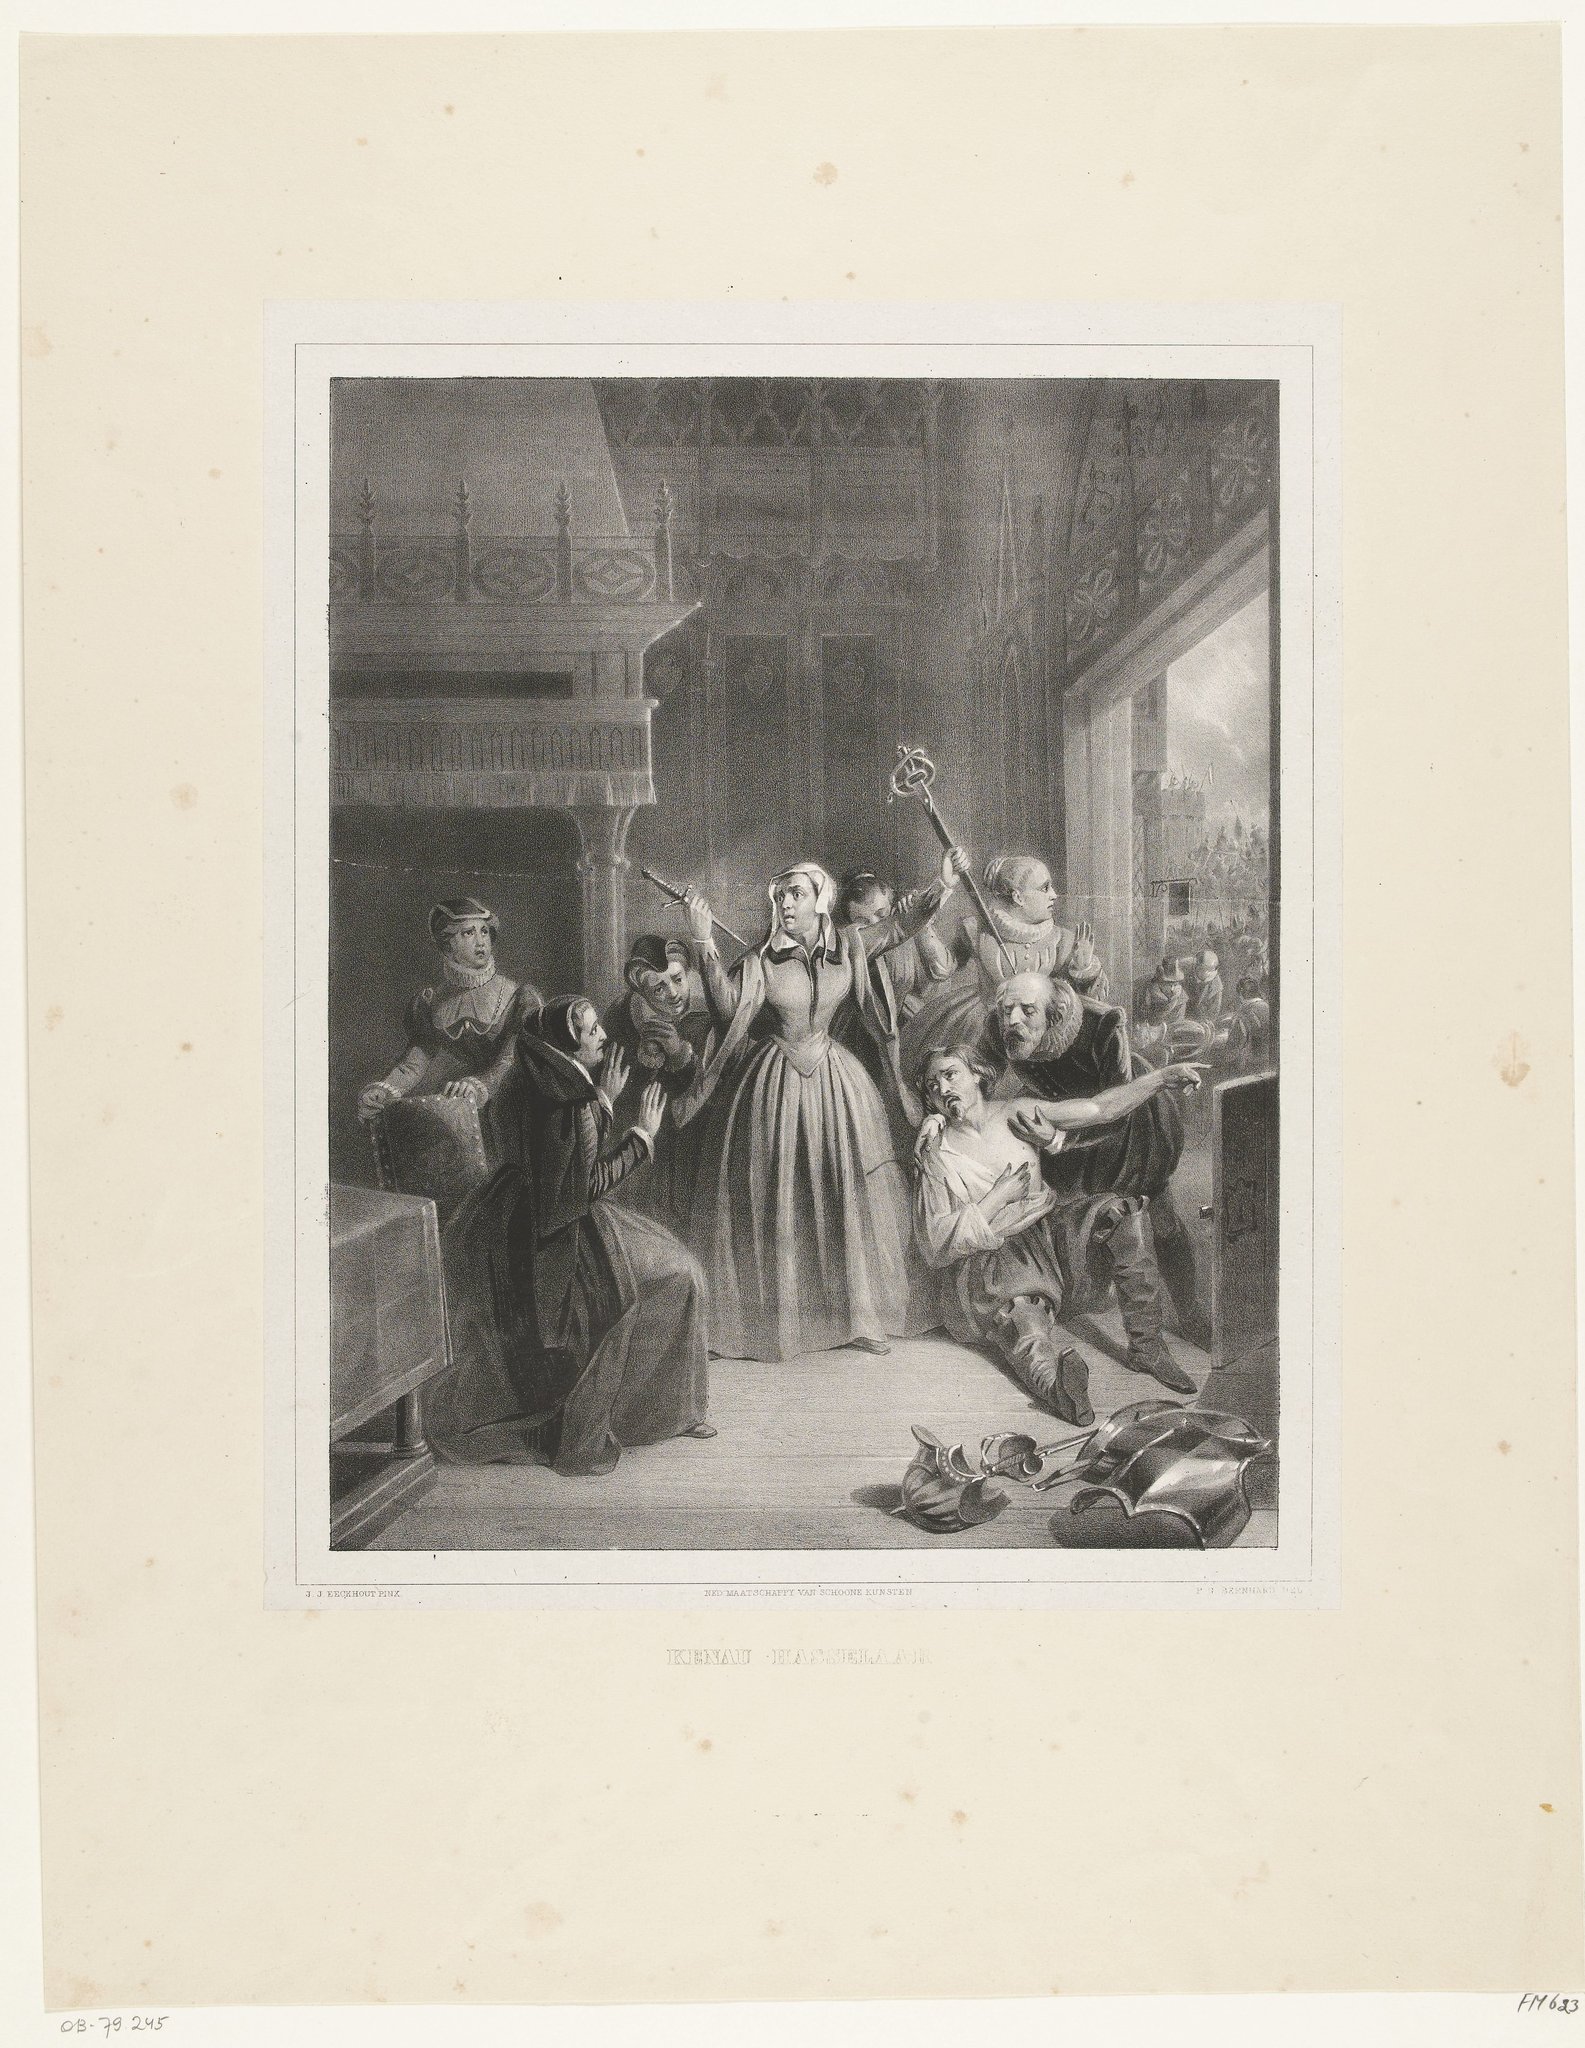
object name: history print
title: Kenau grijpt naar de wapens, 1573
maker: jacob joseph eeckhout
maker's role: draughtsman, print maker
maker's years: 1793-1861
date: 1841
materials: paper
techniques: lithograph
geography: the hague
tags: haarlem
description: Illustratie voor: Neerlands eerezuil of geschiedkundige tafereelen van Neerlands roemruchtige daden door de voornaamste nederlandsche kunstenaars, Nederlandsche maatschappij van schoone kunsten, ’s-Gravenhage 1841. Zonder de bij Muller vermelde afzonderlijke Holl. uitlegging.